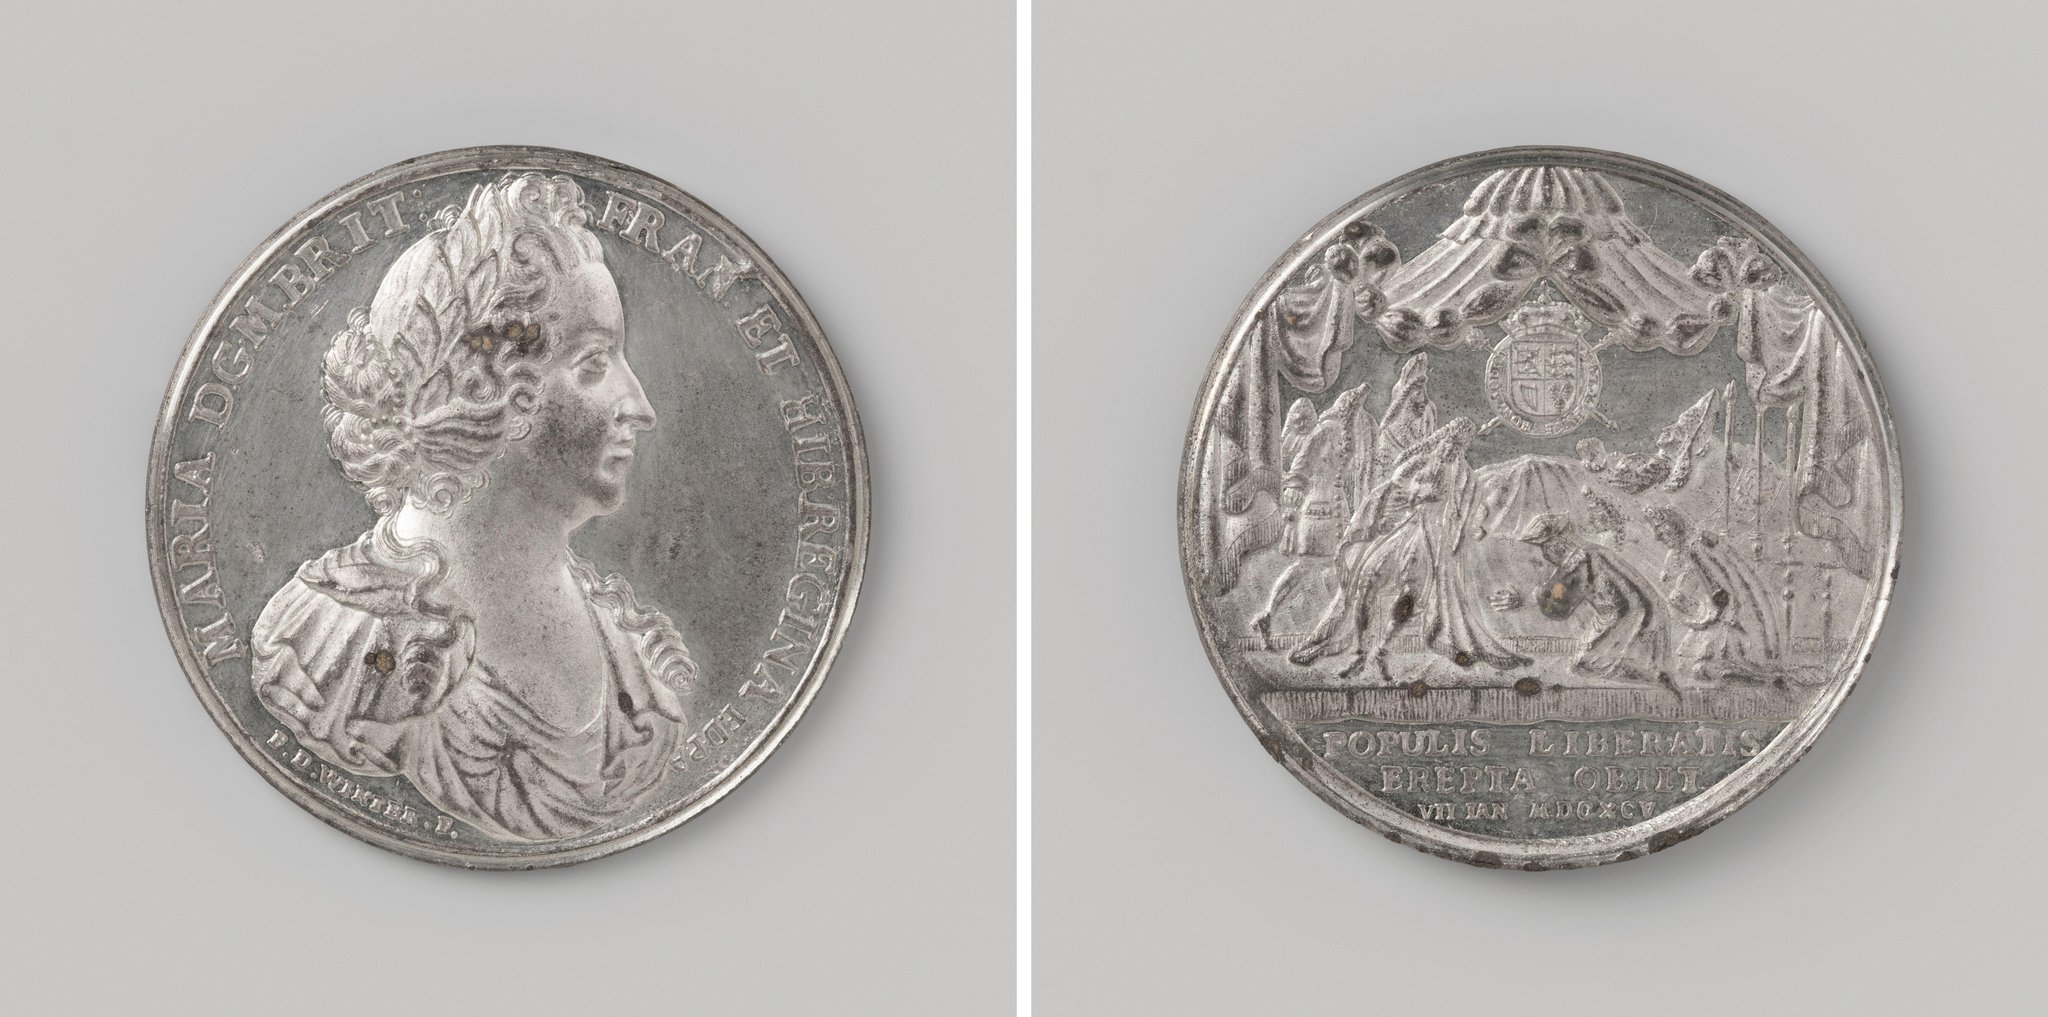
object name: copy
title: Overlijden van Maria II van Engeland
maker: franciscus de winter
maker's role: medailleur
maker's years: 1649-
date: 1695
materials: silver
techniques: striking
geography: london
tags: the hague, william iii (prince of orange and king of england, scotland, and ireland), maria ii stuart (koningin van engeland, schotland en ierland)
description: Zilveren penning. Voorzijde: borststuk vrouw met lauwerkrans binnen omschrift. Keerzijde: overledene opgebaard op bed, aan voet rouwende koning met gevolg, voor bed knielende bisschop en twee edelen; afsnede: opschrift.